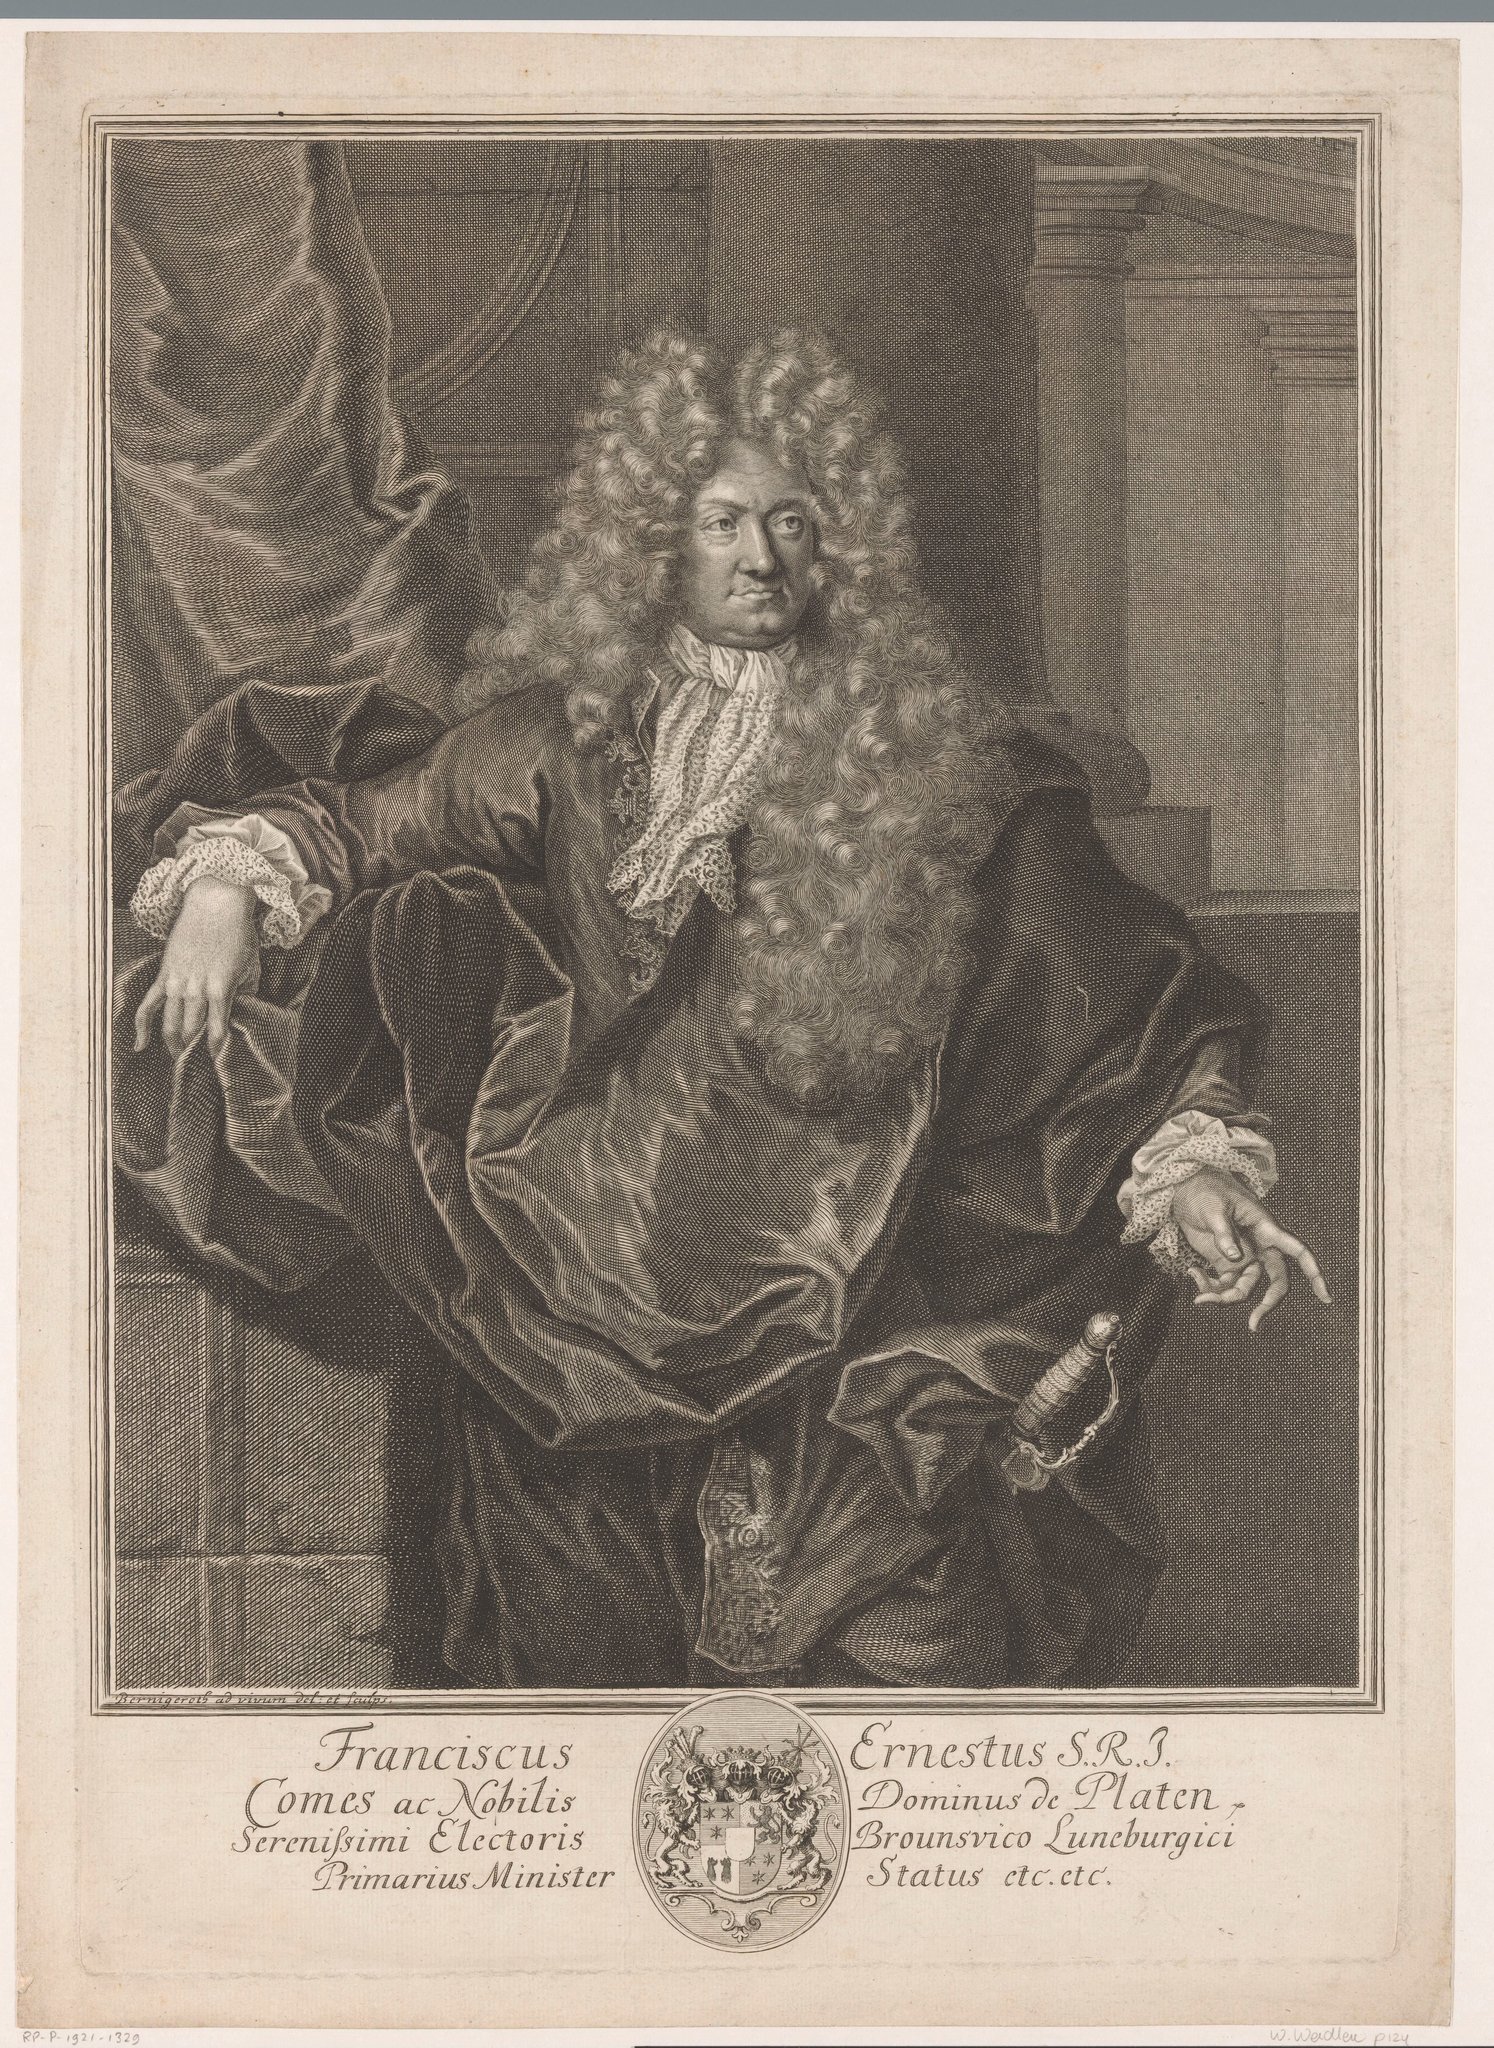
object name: print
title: Portret van Franz Ernst, Reichsgraf von Platen-Hallermund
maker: johann martin bernigeroth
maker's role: print maker, publisher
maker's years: 1713-1767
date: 1723-1767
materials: paper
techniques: engraving, etching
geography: leipzig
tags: historical persons, armorial bearing, heraldry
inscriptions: collector's mark: Lugt 2233